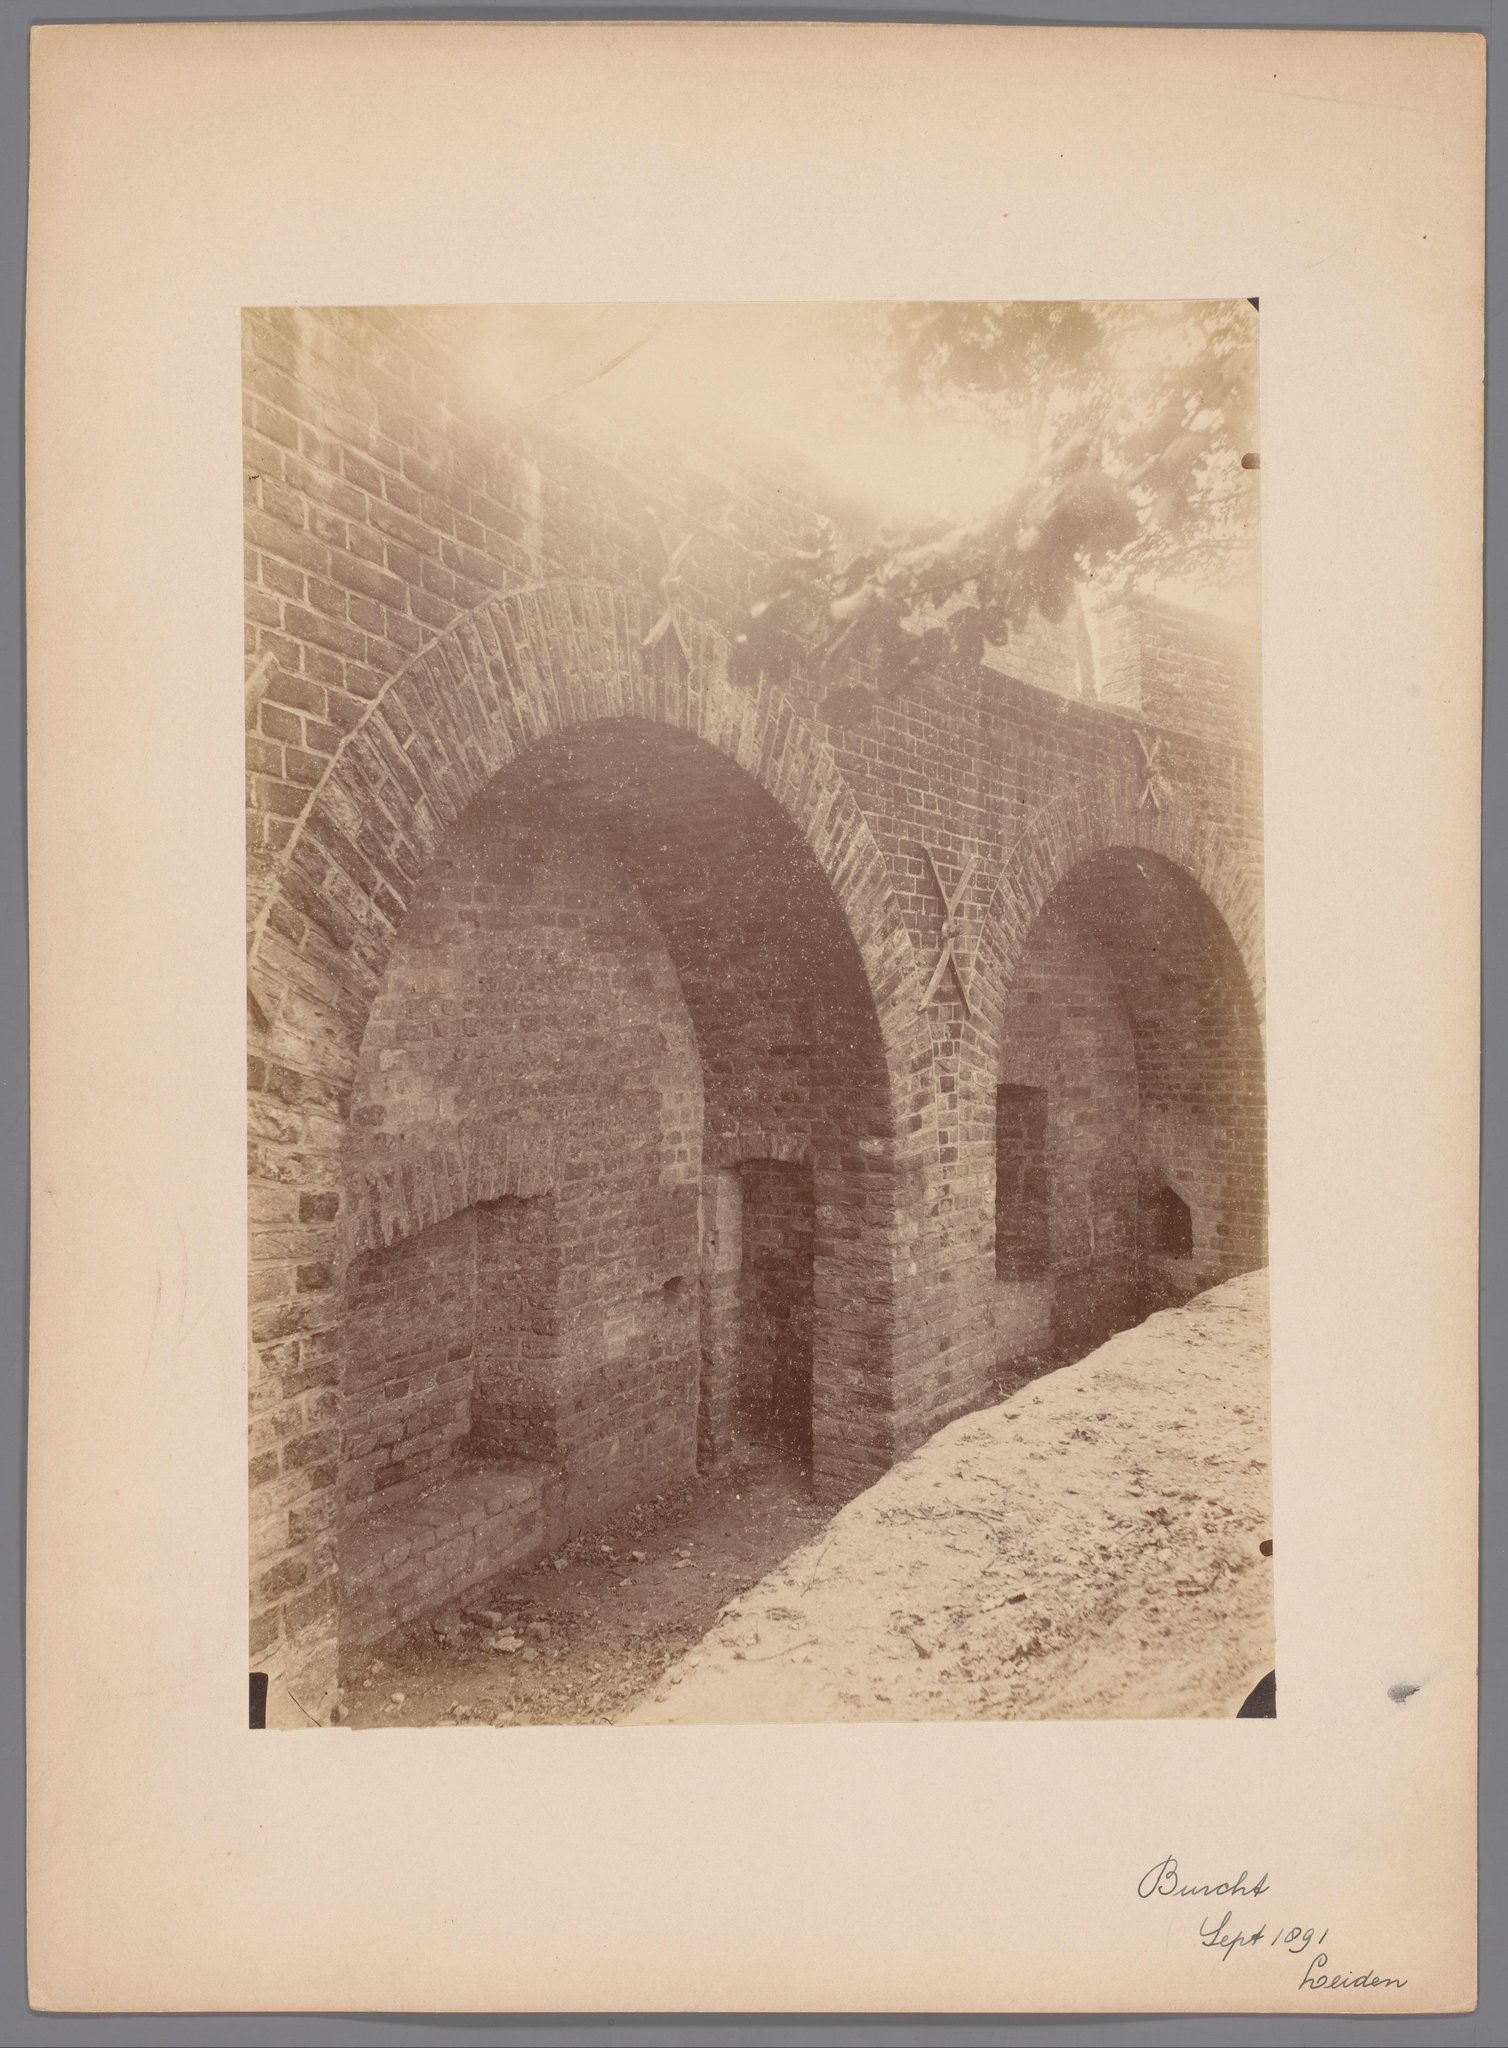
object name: photograph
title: Twee schietgaten van de Burcht van Leiden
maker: anoniem (monumentenzorg)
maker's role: fotograaf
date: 1891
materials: cardboard, photographic support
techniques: albumen print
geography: burcht van leiden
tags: castle, loop-hole ~ fortified city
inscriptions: annotation: ‘Burgt te Leiden/ gerestaureerde bogen N:6 en N:7/ N:6 heeft de uitgang naar buiten/ sept. 1891’, annotation: ‘Burcht/ Sept. 1891/ Leiden’